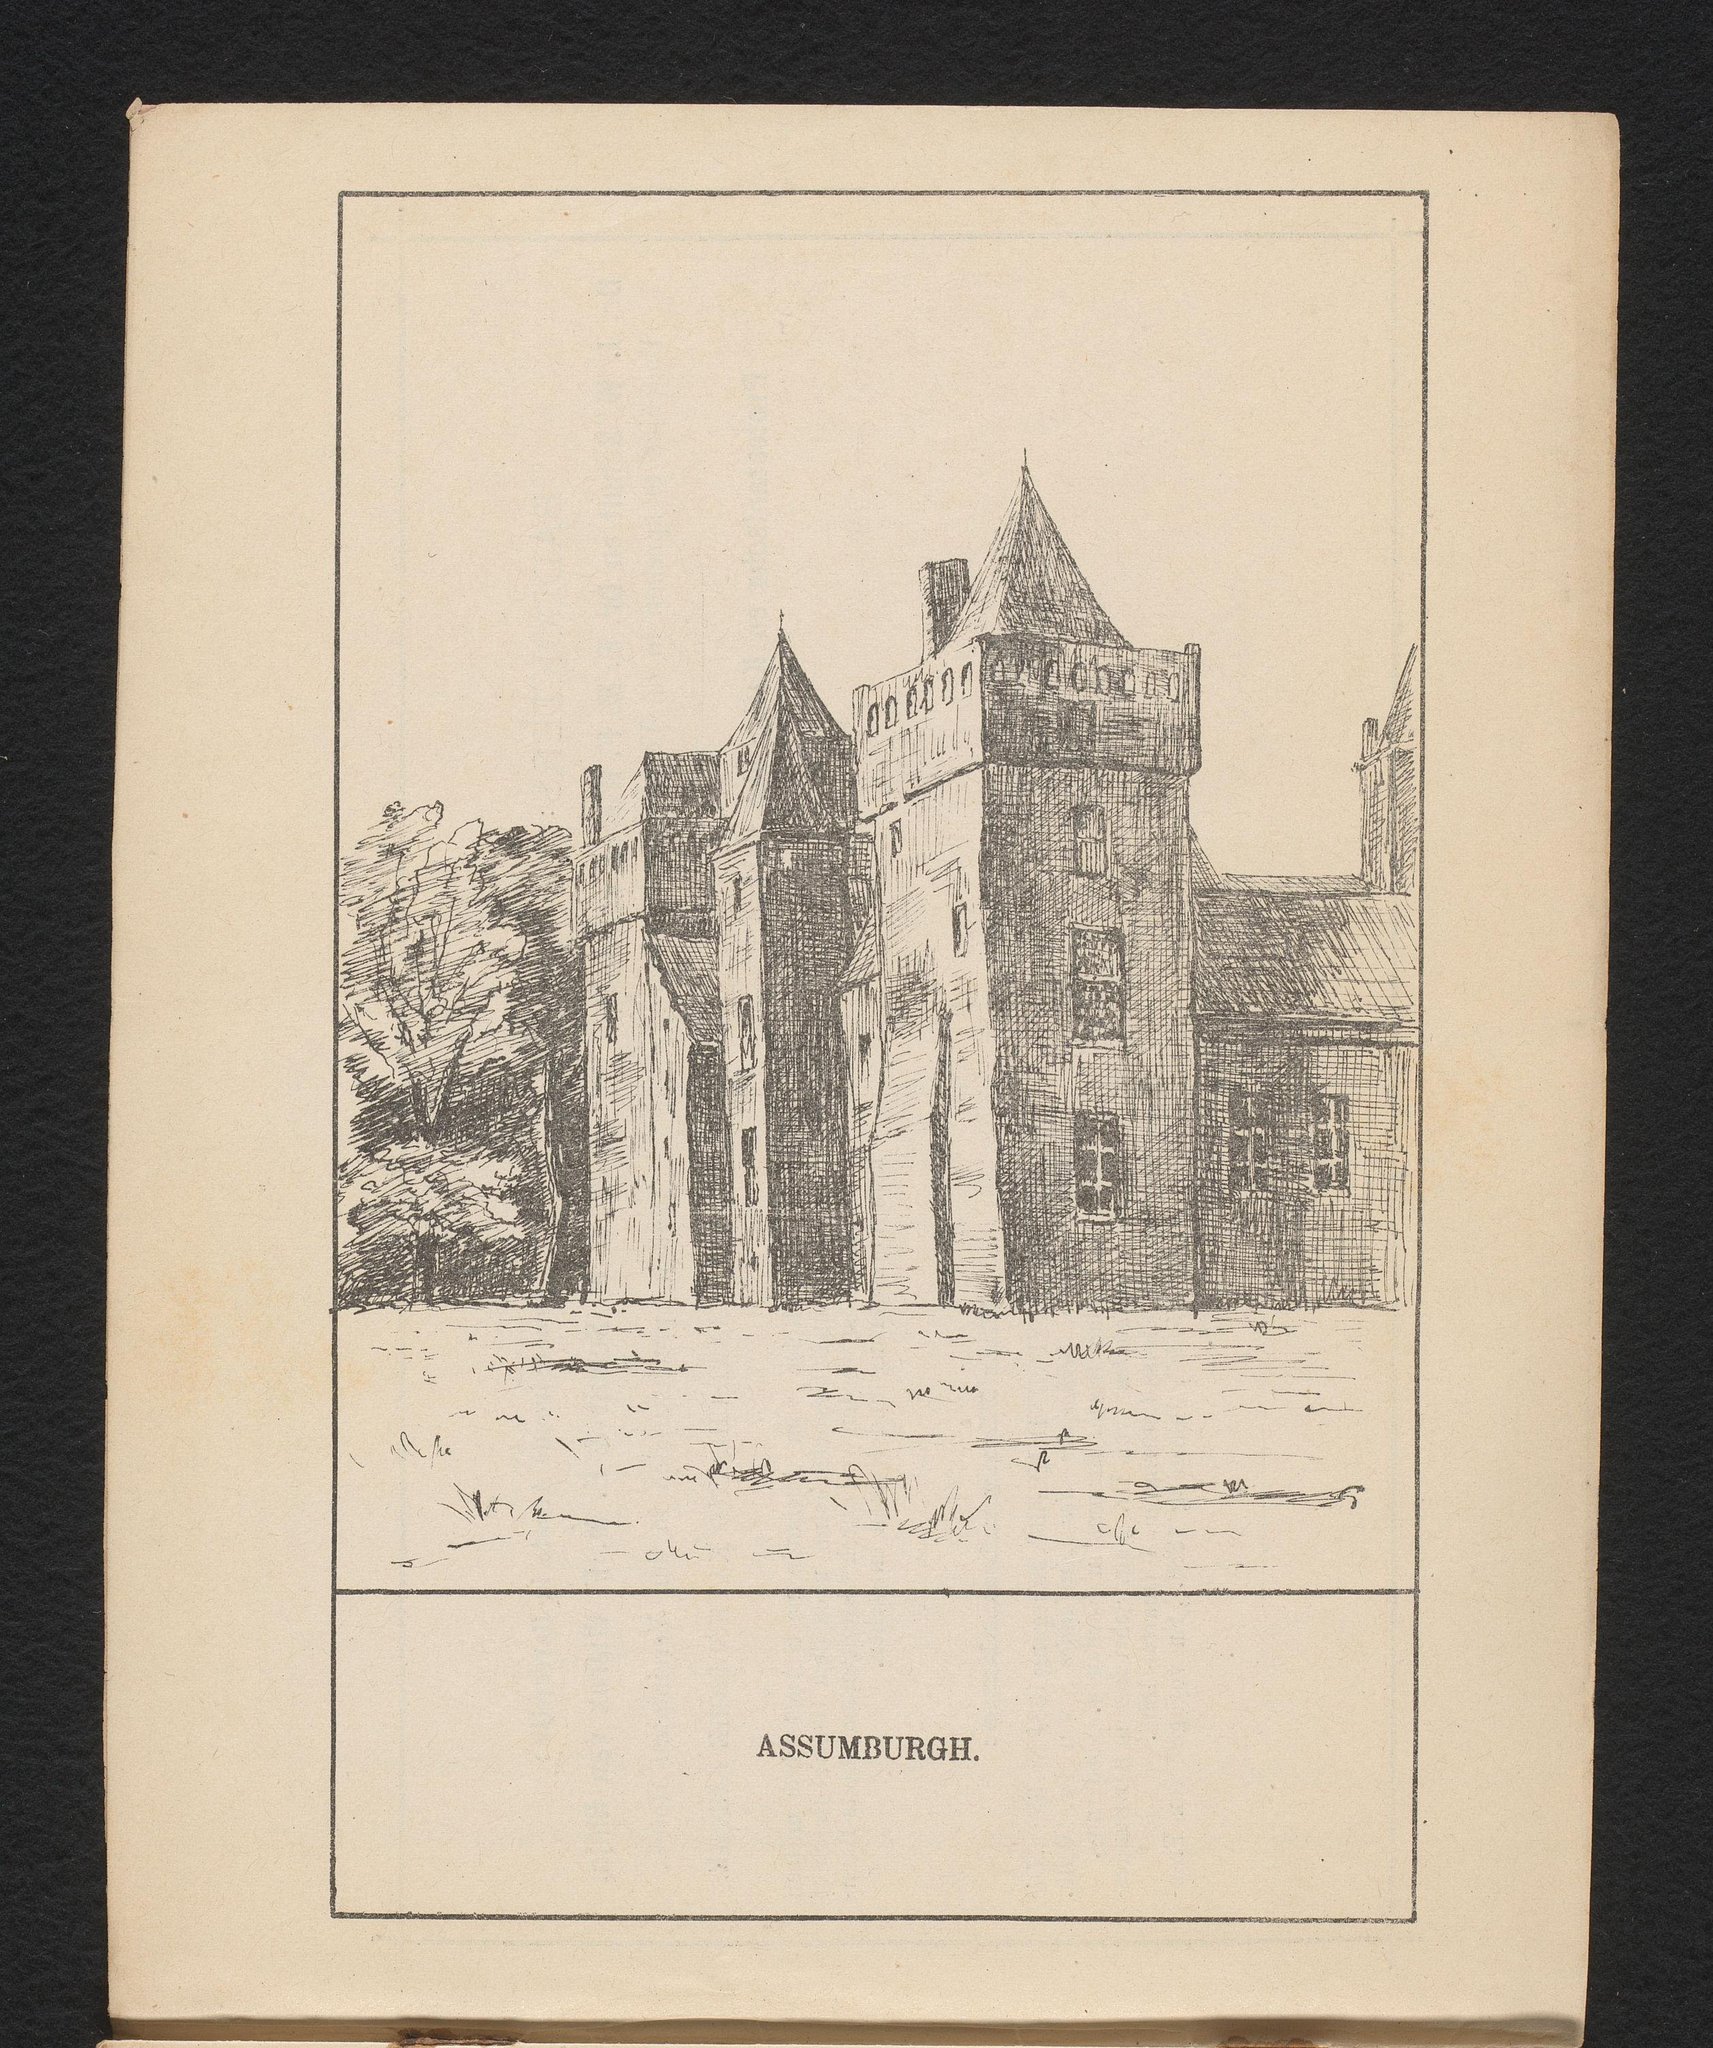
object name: book illustration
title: Assumburgh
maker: Anonymous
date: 1893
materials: paper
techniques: lithograph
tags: castle